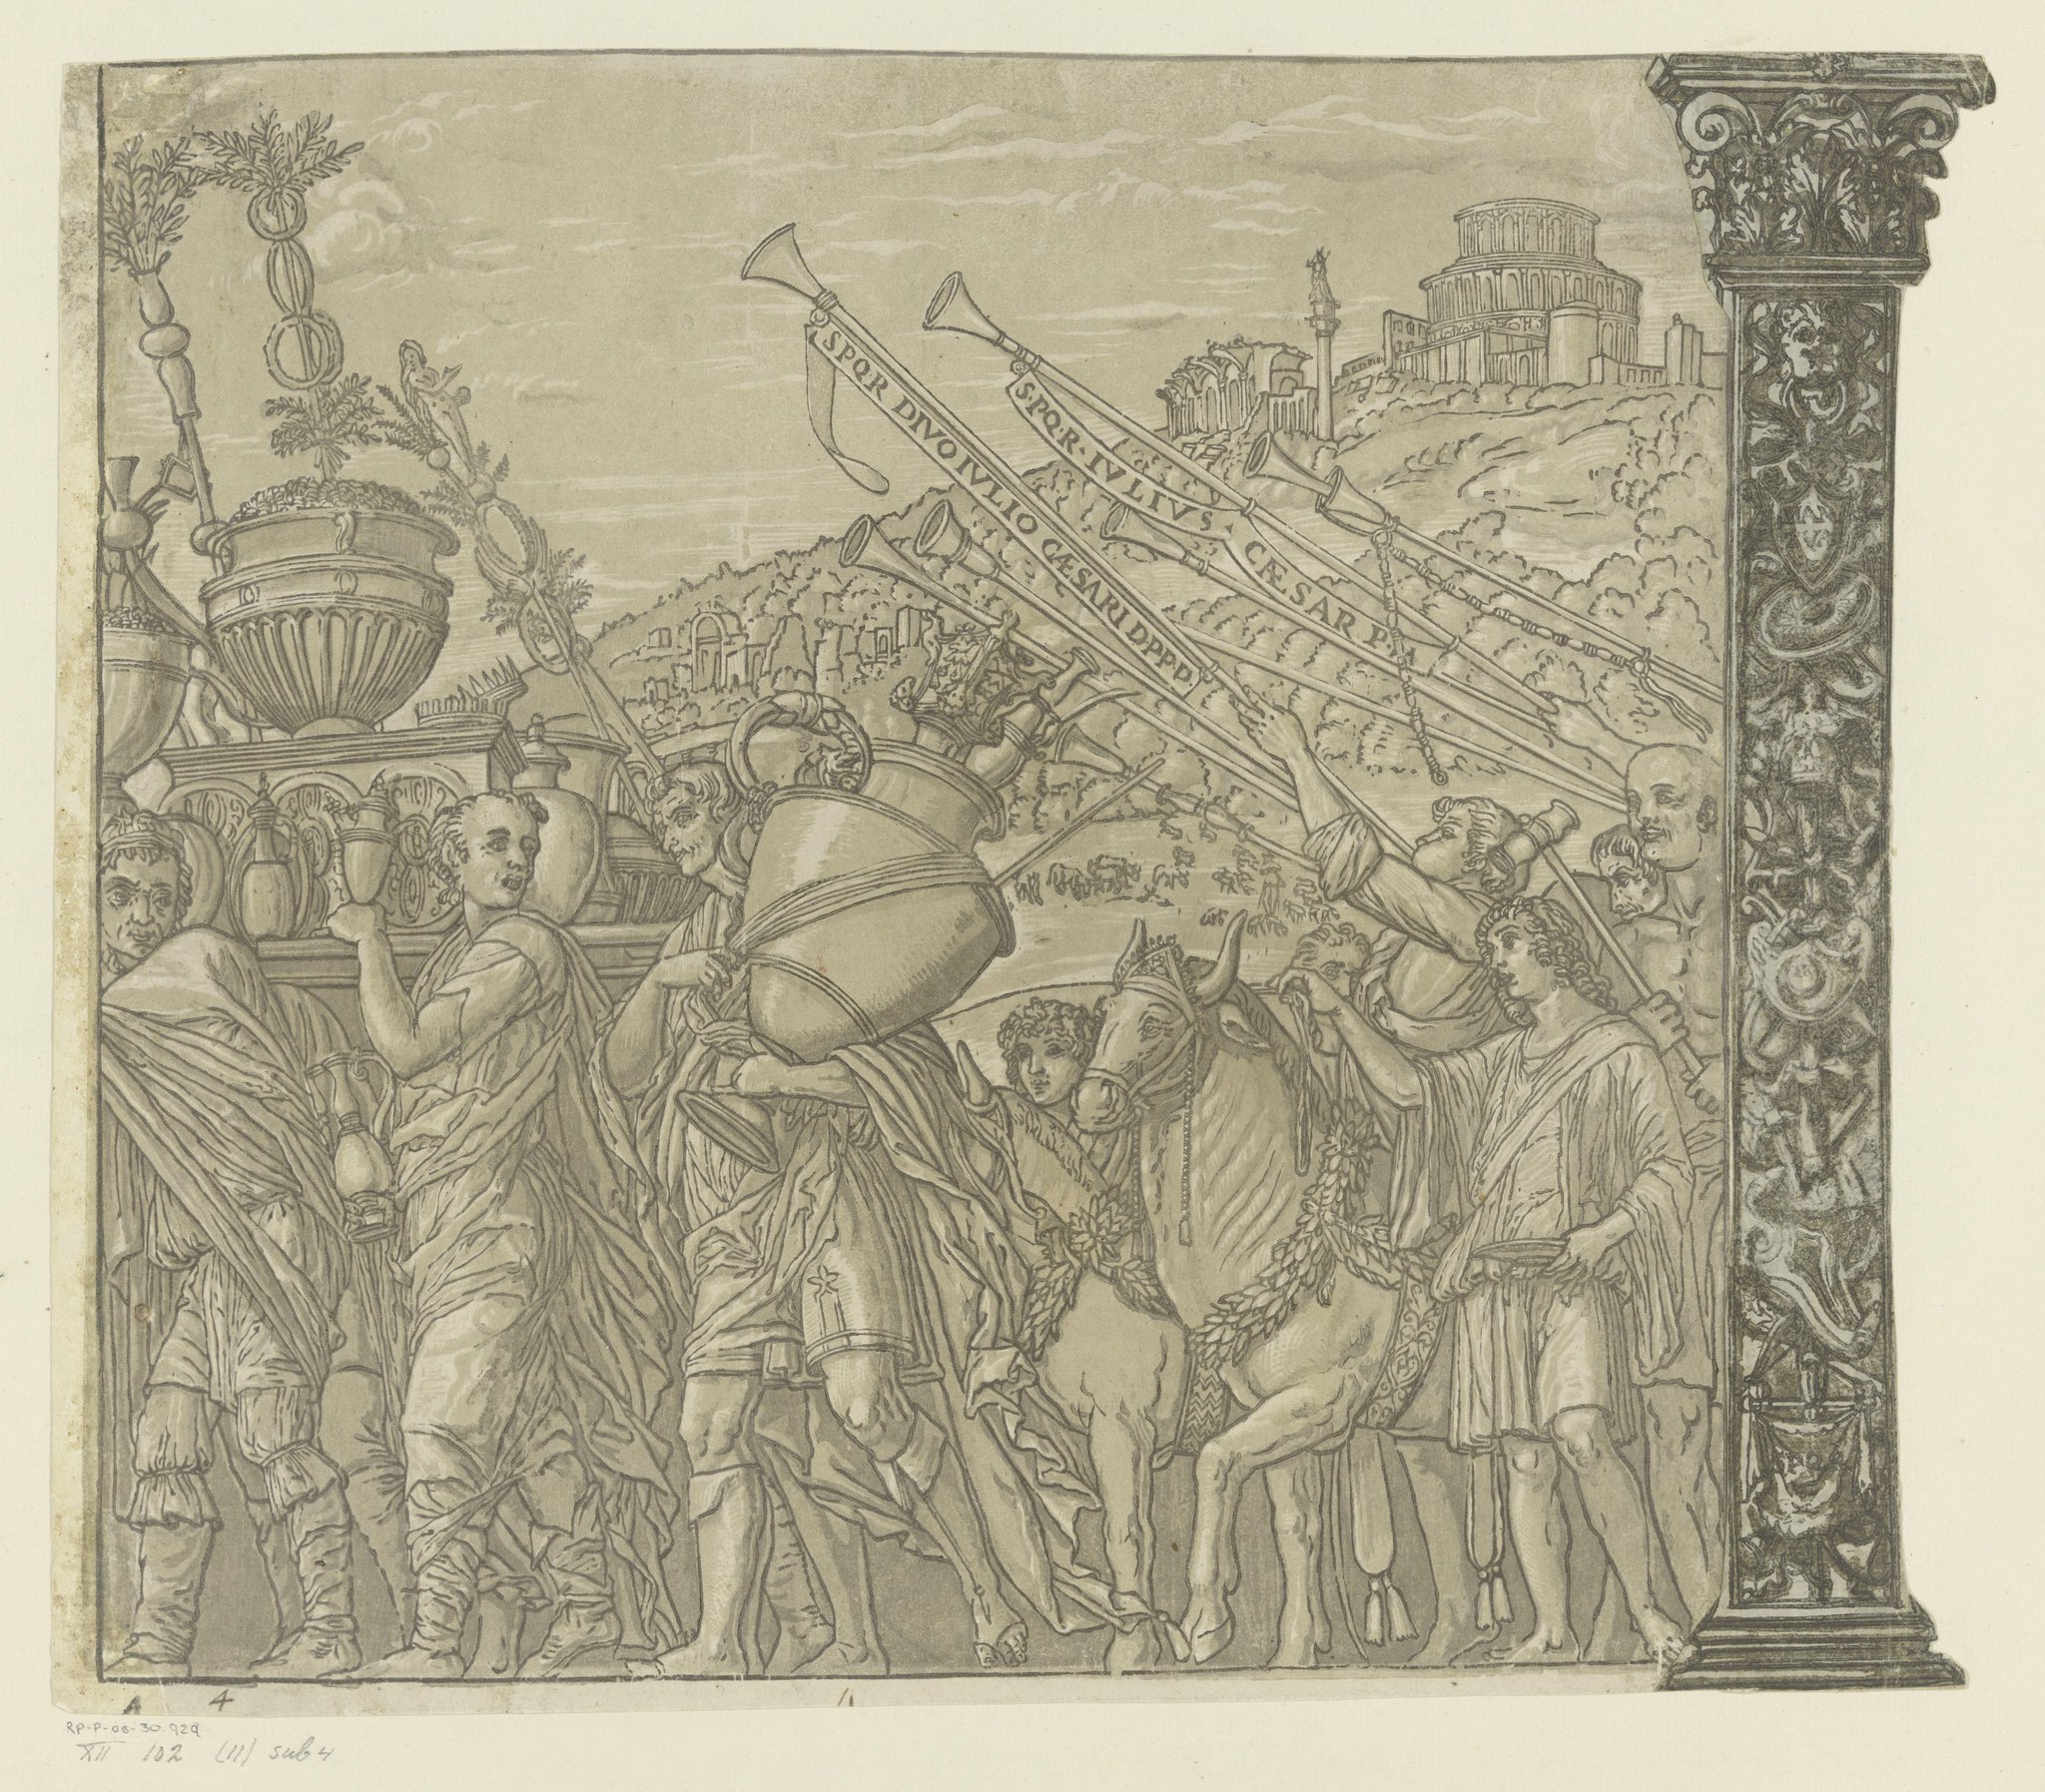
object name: print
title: Triomftocht van Julius Caesar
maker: andrea andreani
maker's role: print maker, printer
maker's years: 1558-1629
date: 1599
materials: paper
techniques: woodcut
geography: mantua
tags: horn, trumpet, cornet, trombone, tuba, triumph of caesar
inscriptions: number: ‘4’, collector's mark: Lugt 240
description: Deze prent maakt deel uit van een fries dat bestaat uit een titelprent en negen prenten die samen een triomftocht van Julius Caesar vormen. Bij de serie hoort tevens een prent met daarop zes Korinthische pilasters, bedoeld om te worden uitgeknipt en gebruikt als verbindingsstukken tussen de verschillende bladen. Op dit exemplaar is een pilaster aan de rechterkant gemonteerd. Op de achterzijde van de pilaster een afdruk van een andere clair-obscur houtsnede.